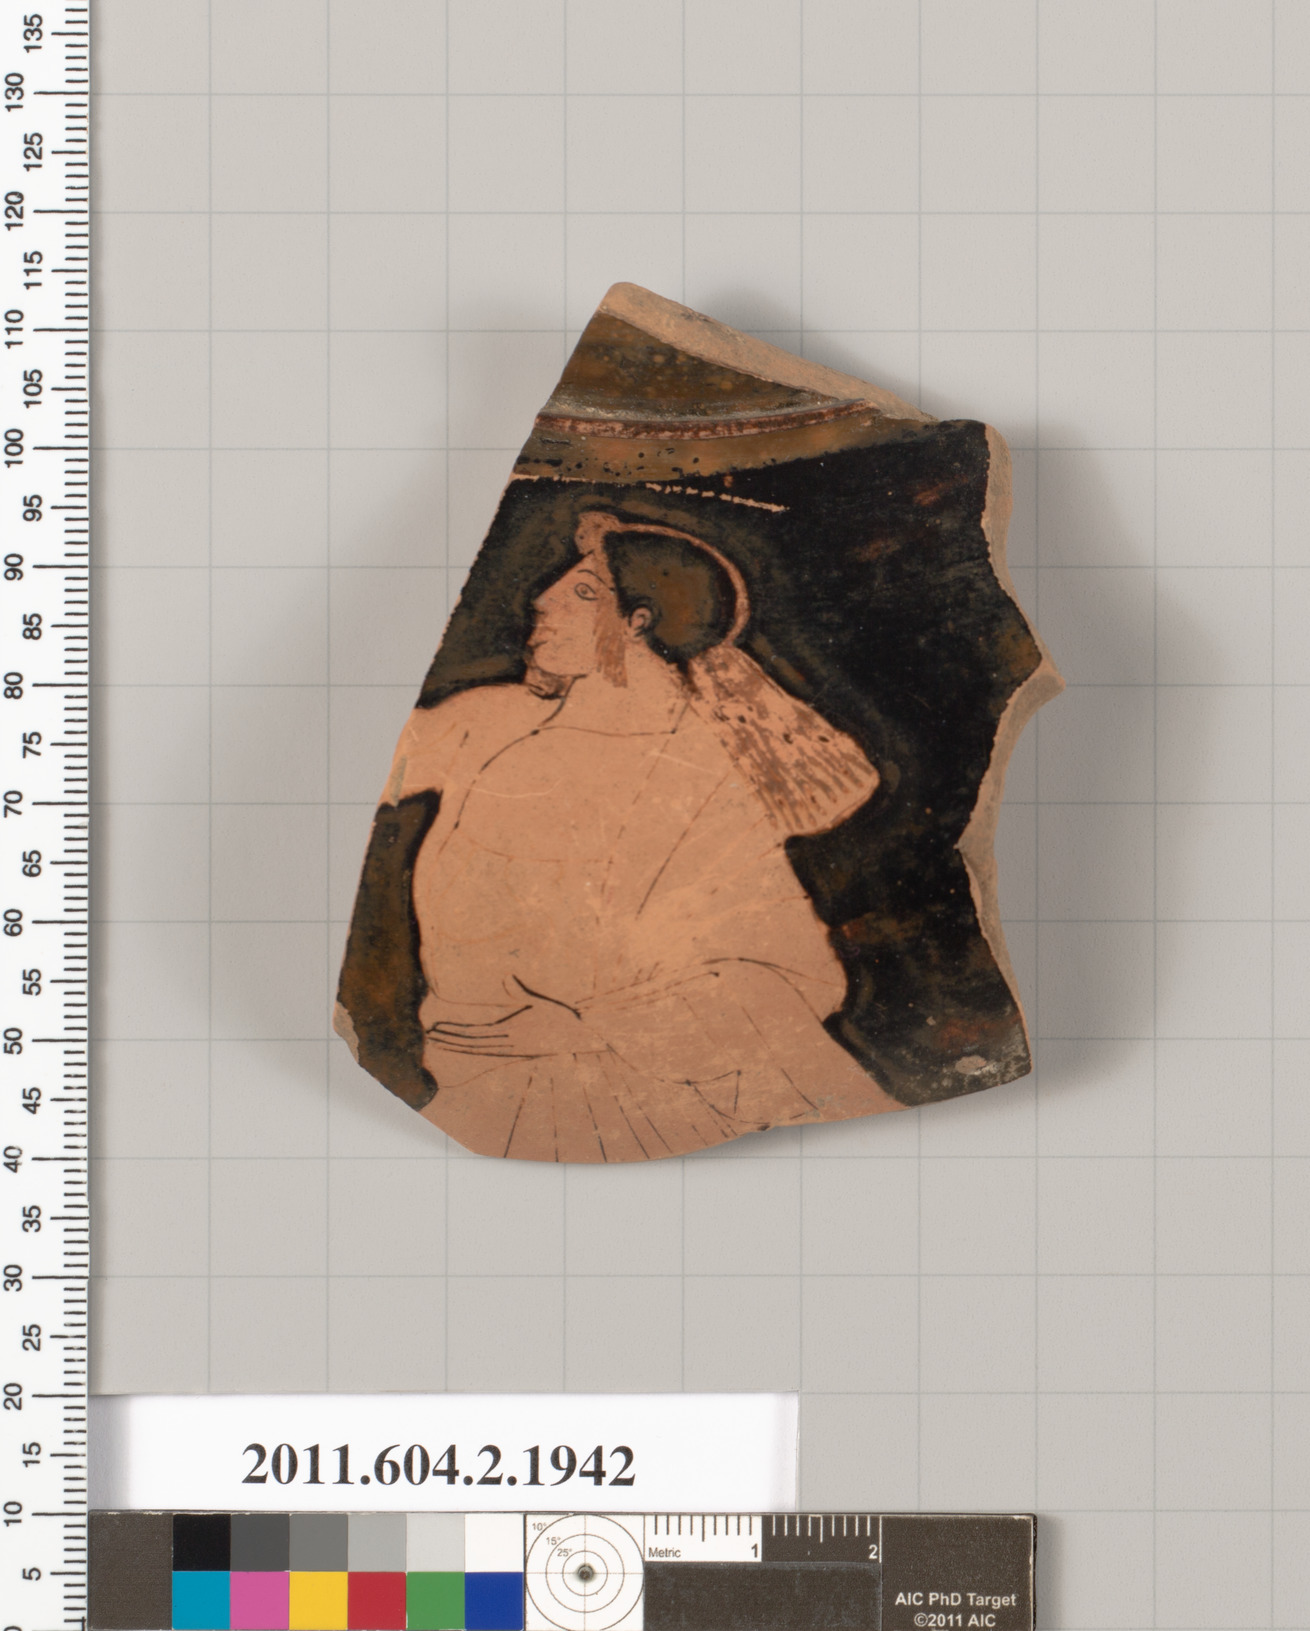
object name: neck amphora fragment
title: Terracotta fragment of a Nolan neck-amphora (jar)?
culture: greek, attic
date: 475-460 BCE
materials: terracotta